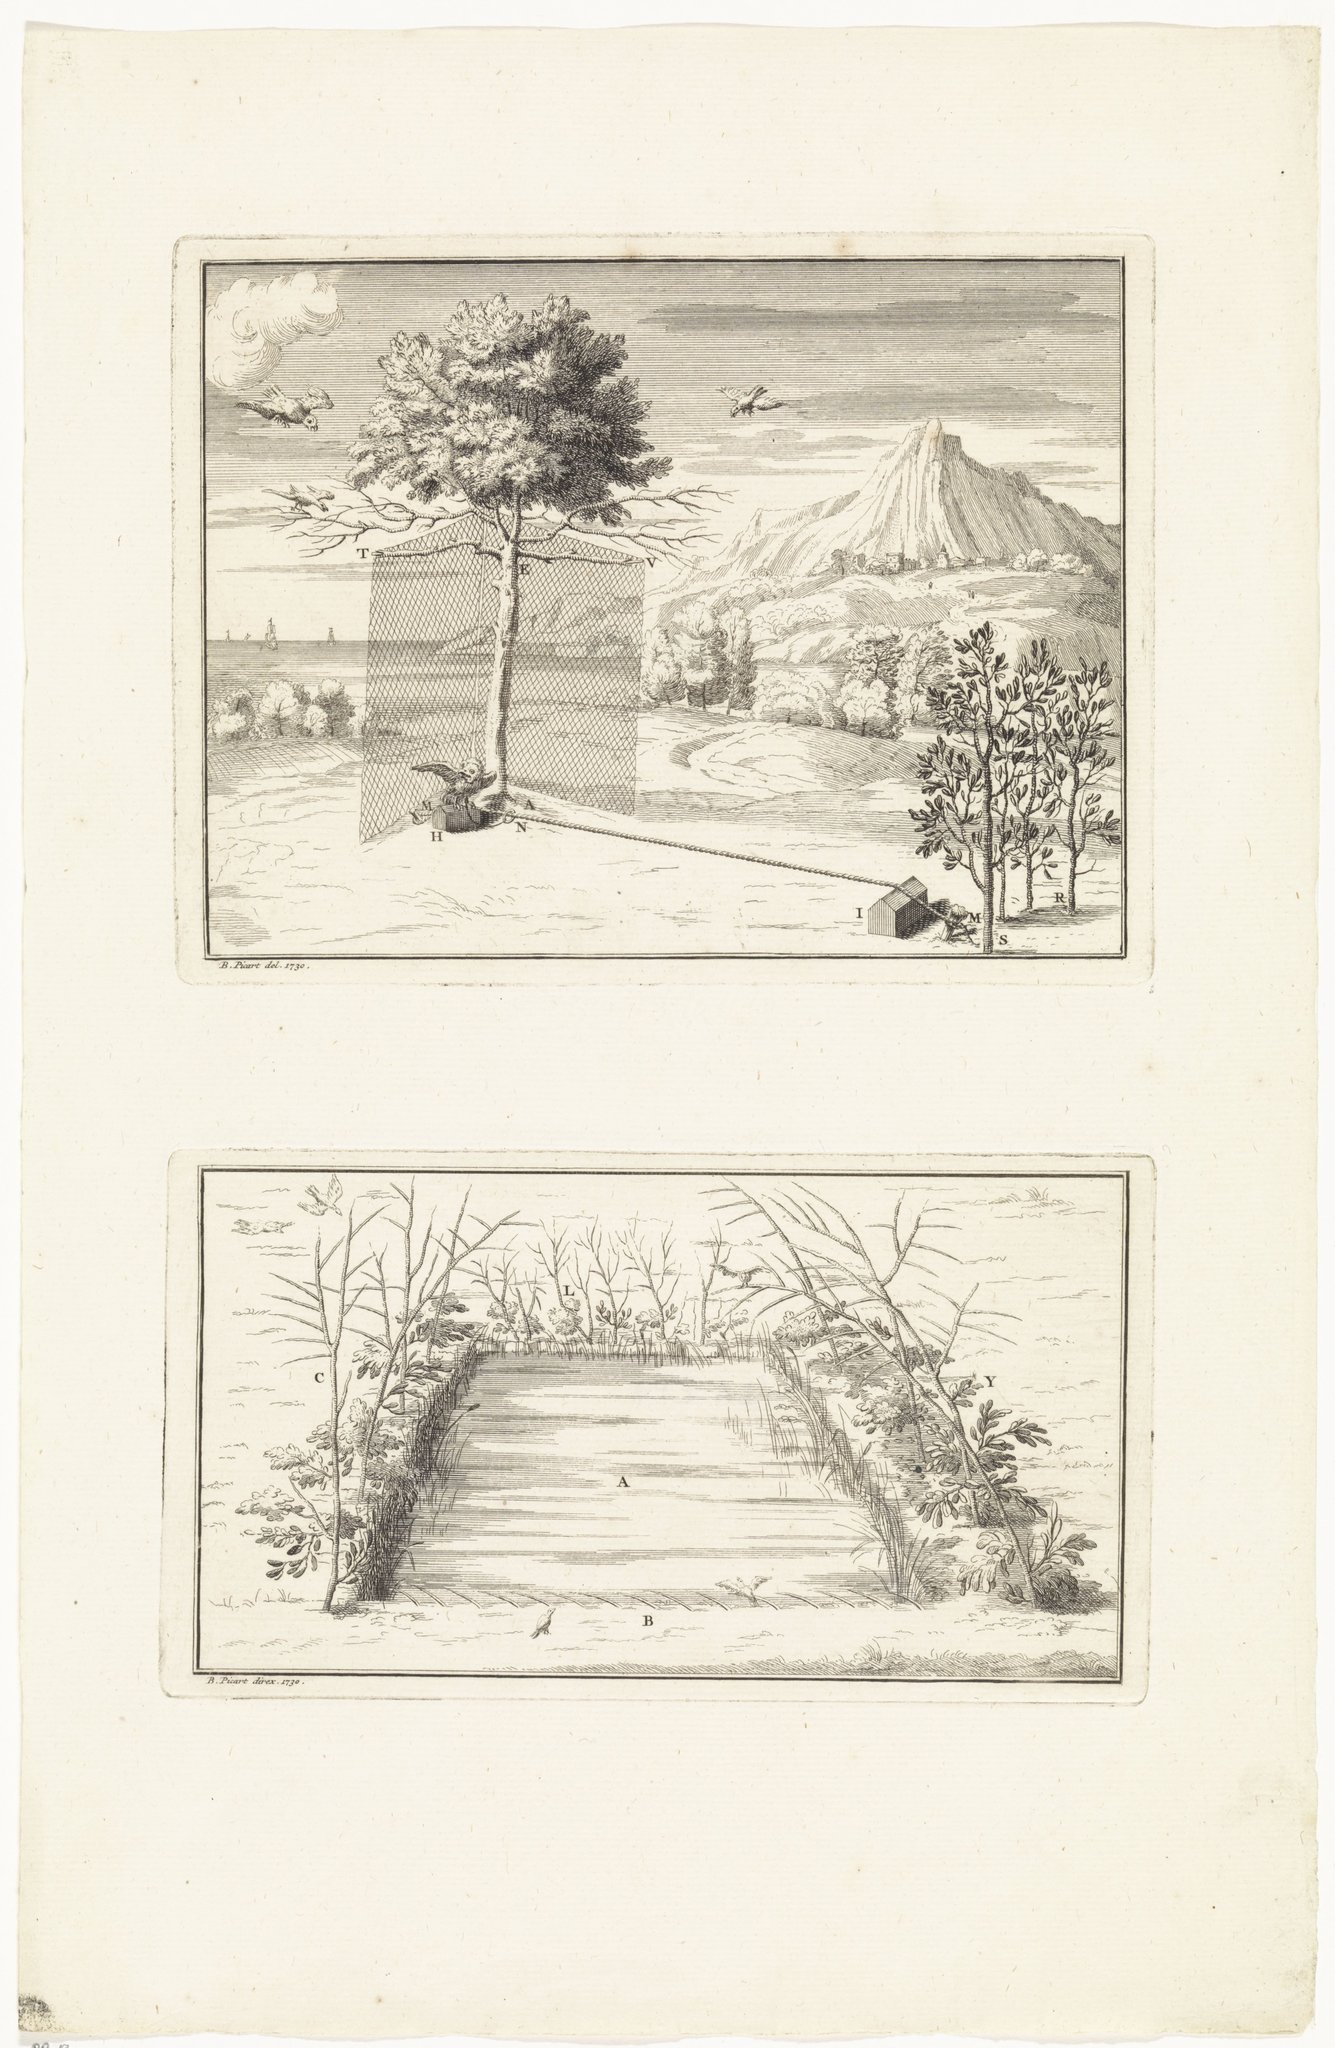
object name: print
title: Net en vijver om vogels te vangen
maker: bernard picart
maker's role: draughtsman, print maker, publisher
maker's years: 1673-1733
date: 1730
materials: paper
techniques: etching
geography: amsterdam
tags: bird hunting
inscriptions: collector's mark: Lugt 2233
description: Twee voorstellingen op een blad. Boven: Onder een boom is een net gespannen en lokt een geketende uil vogels naar de boom. De kale takken van de boom zijn geprepareerd met lijm om ze te vangen. Onder: Lokvijver met verschillende met lijm geprepareerde kale takken en staken om vogels te vangen.